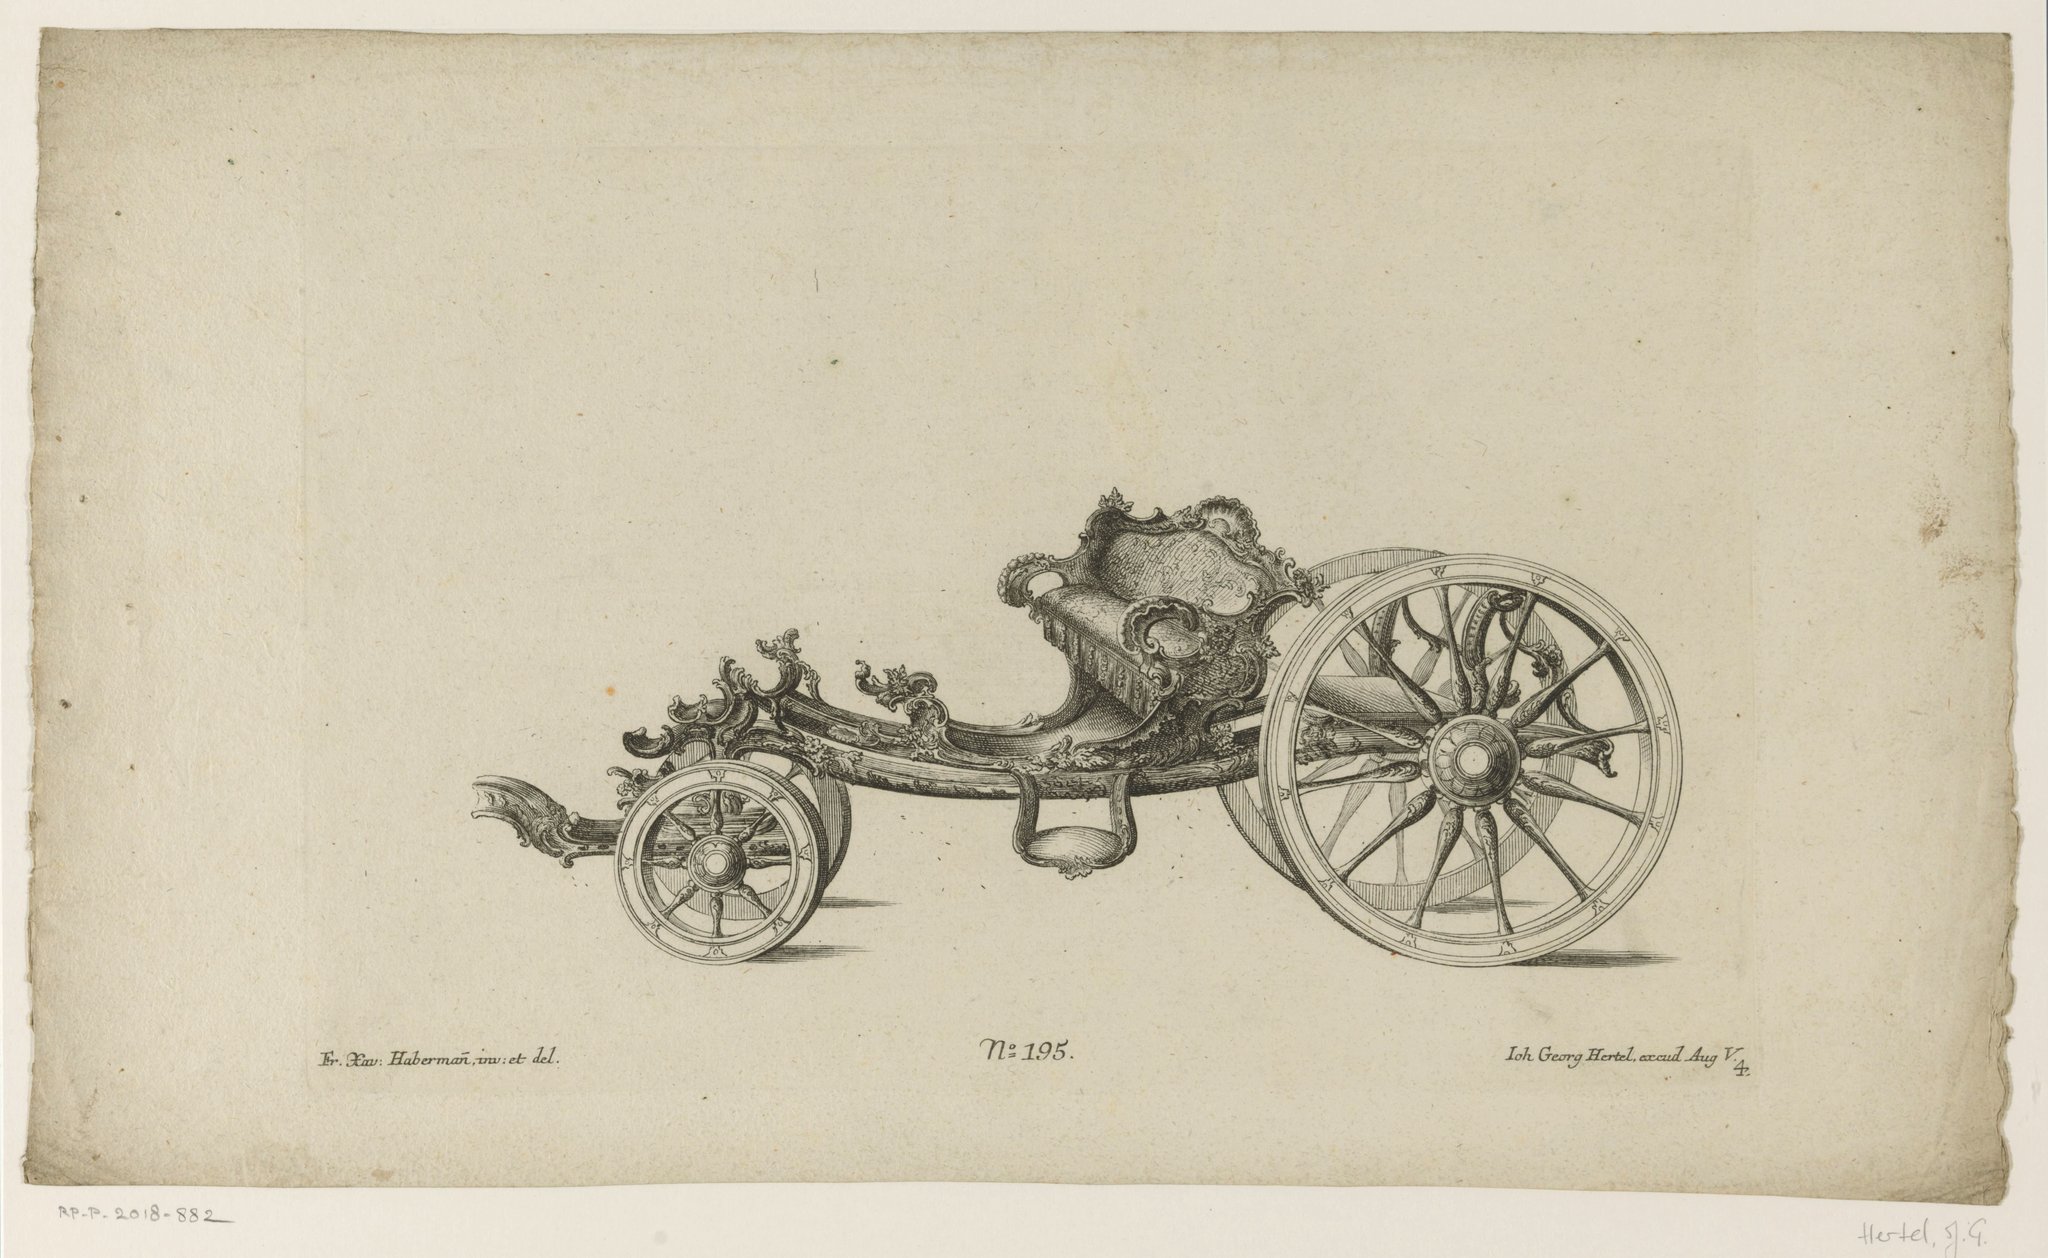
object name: print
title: Rijtuigen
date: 1731-1775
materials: paper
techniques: engraving, etching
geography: augsburg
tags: four-wheeled, animal-drawn vehicle, e.g.: cab, carriage, coach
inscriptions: collector's mark: Lugt 2228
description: Open koets met rocaille ornamenten en bladmotieven. Uitgeversnummer 195.